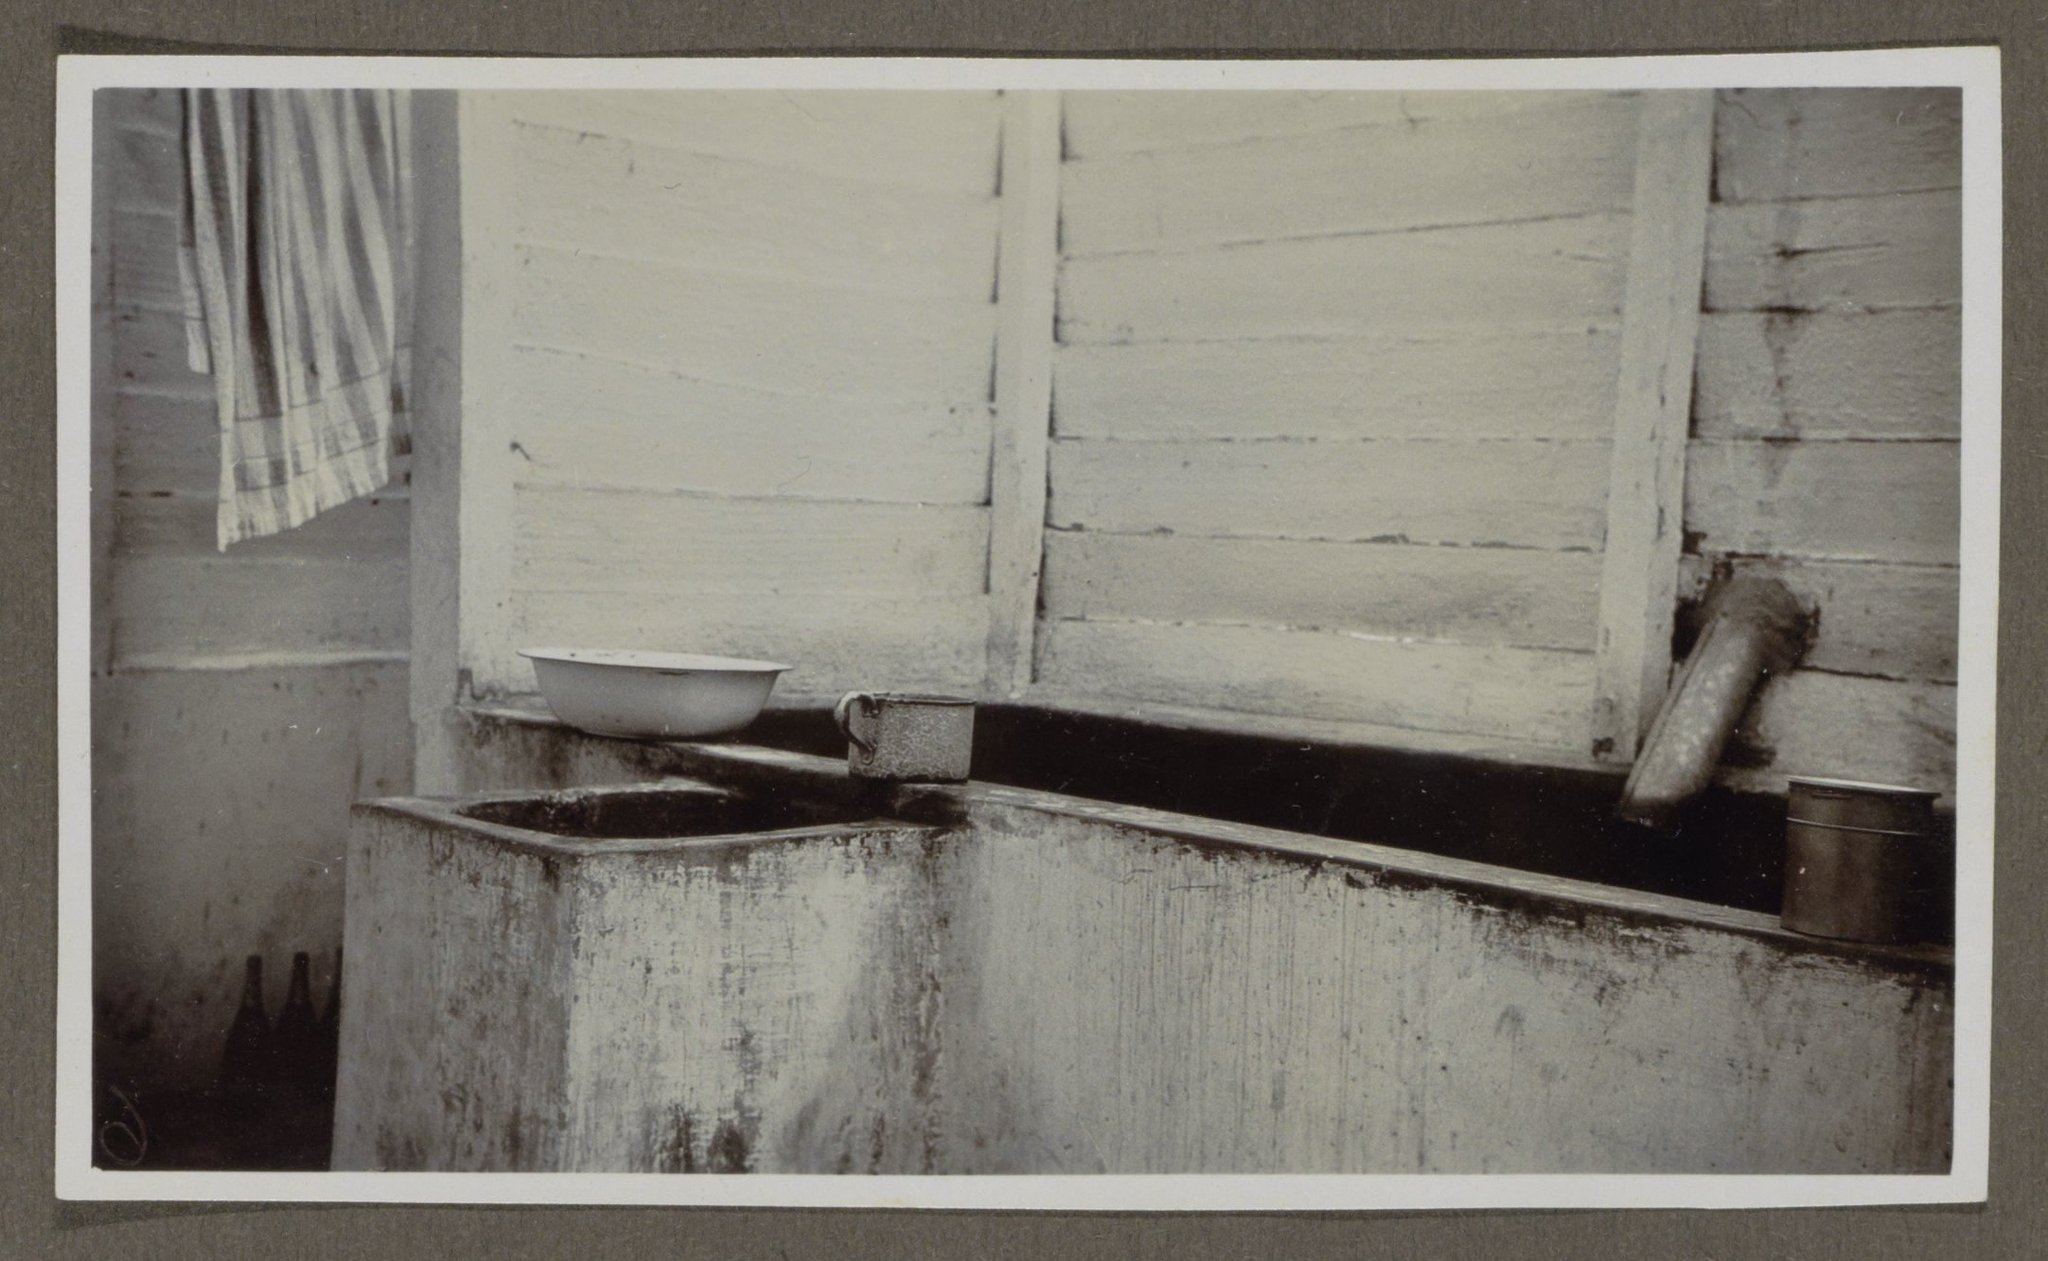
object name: photograph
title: Spoelbak met keukengerei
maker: Anonymous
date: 1920-1930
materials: photographic support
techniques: gelatin silver print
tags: sink (kitchen), dutch east indies, the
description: Onderdeel van familiealbum Nederlands-Indië.